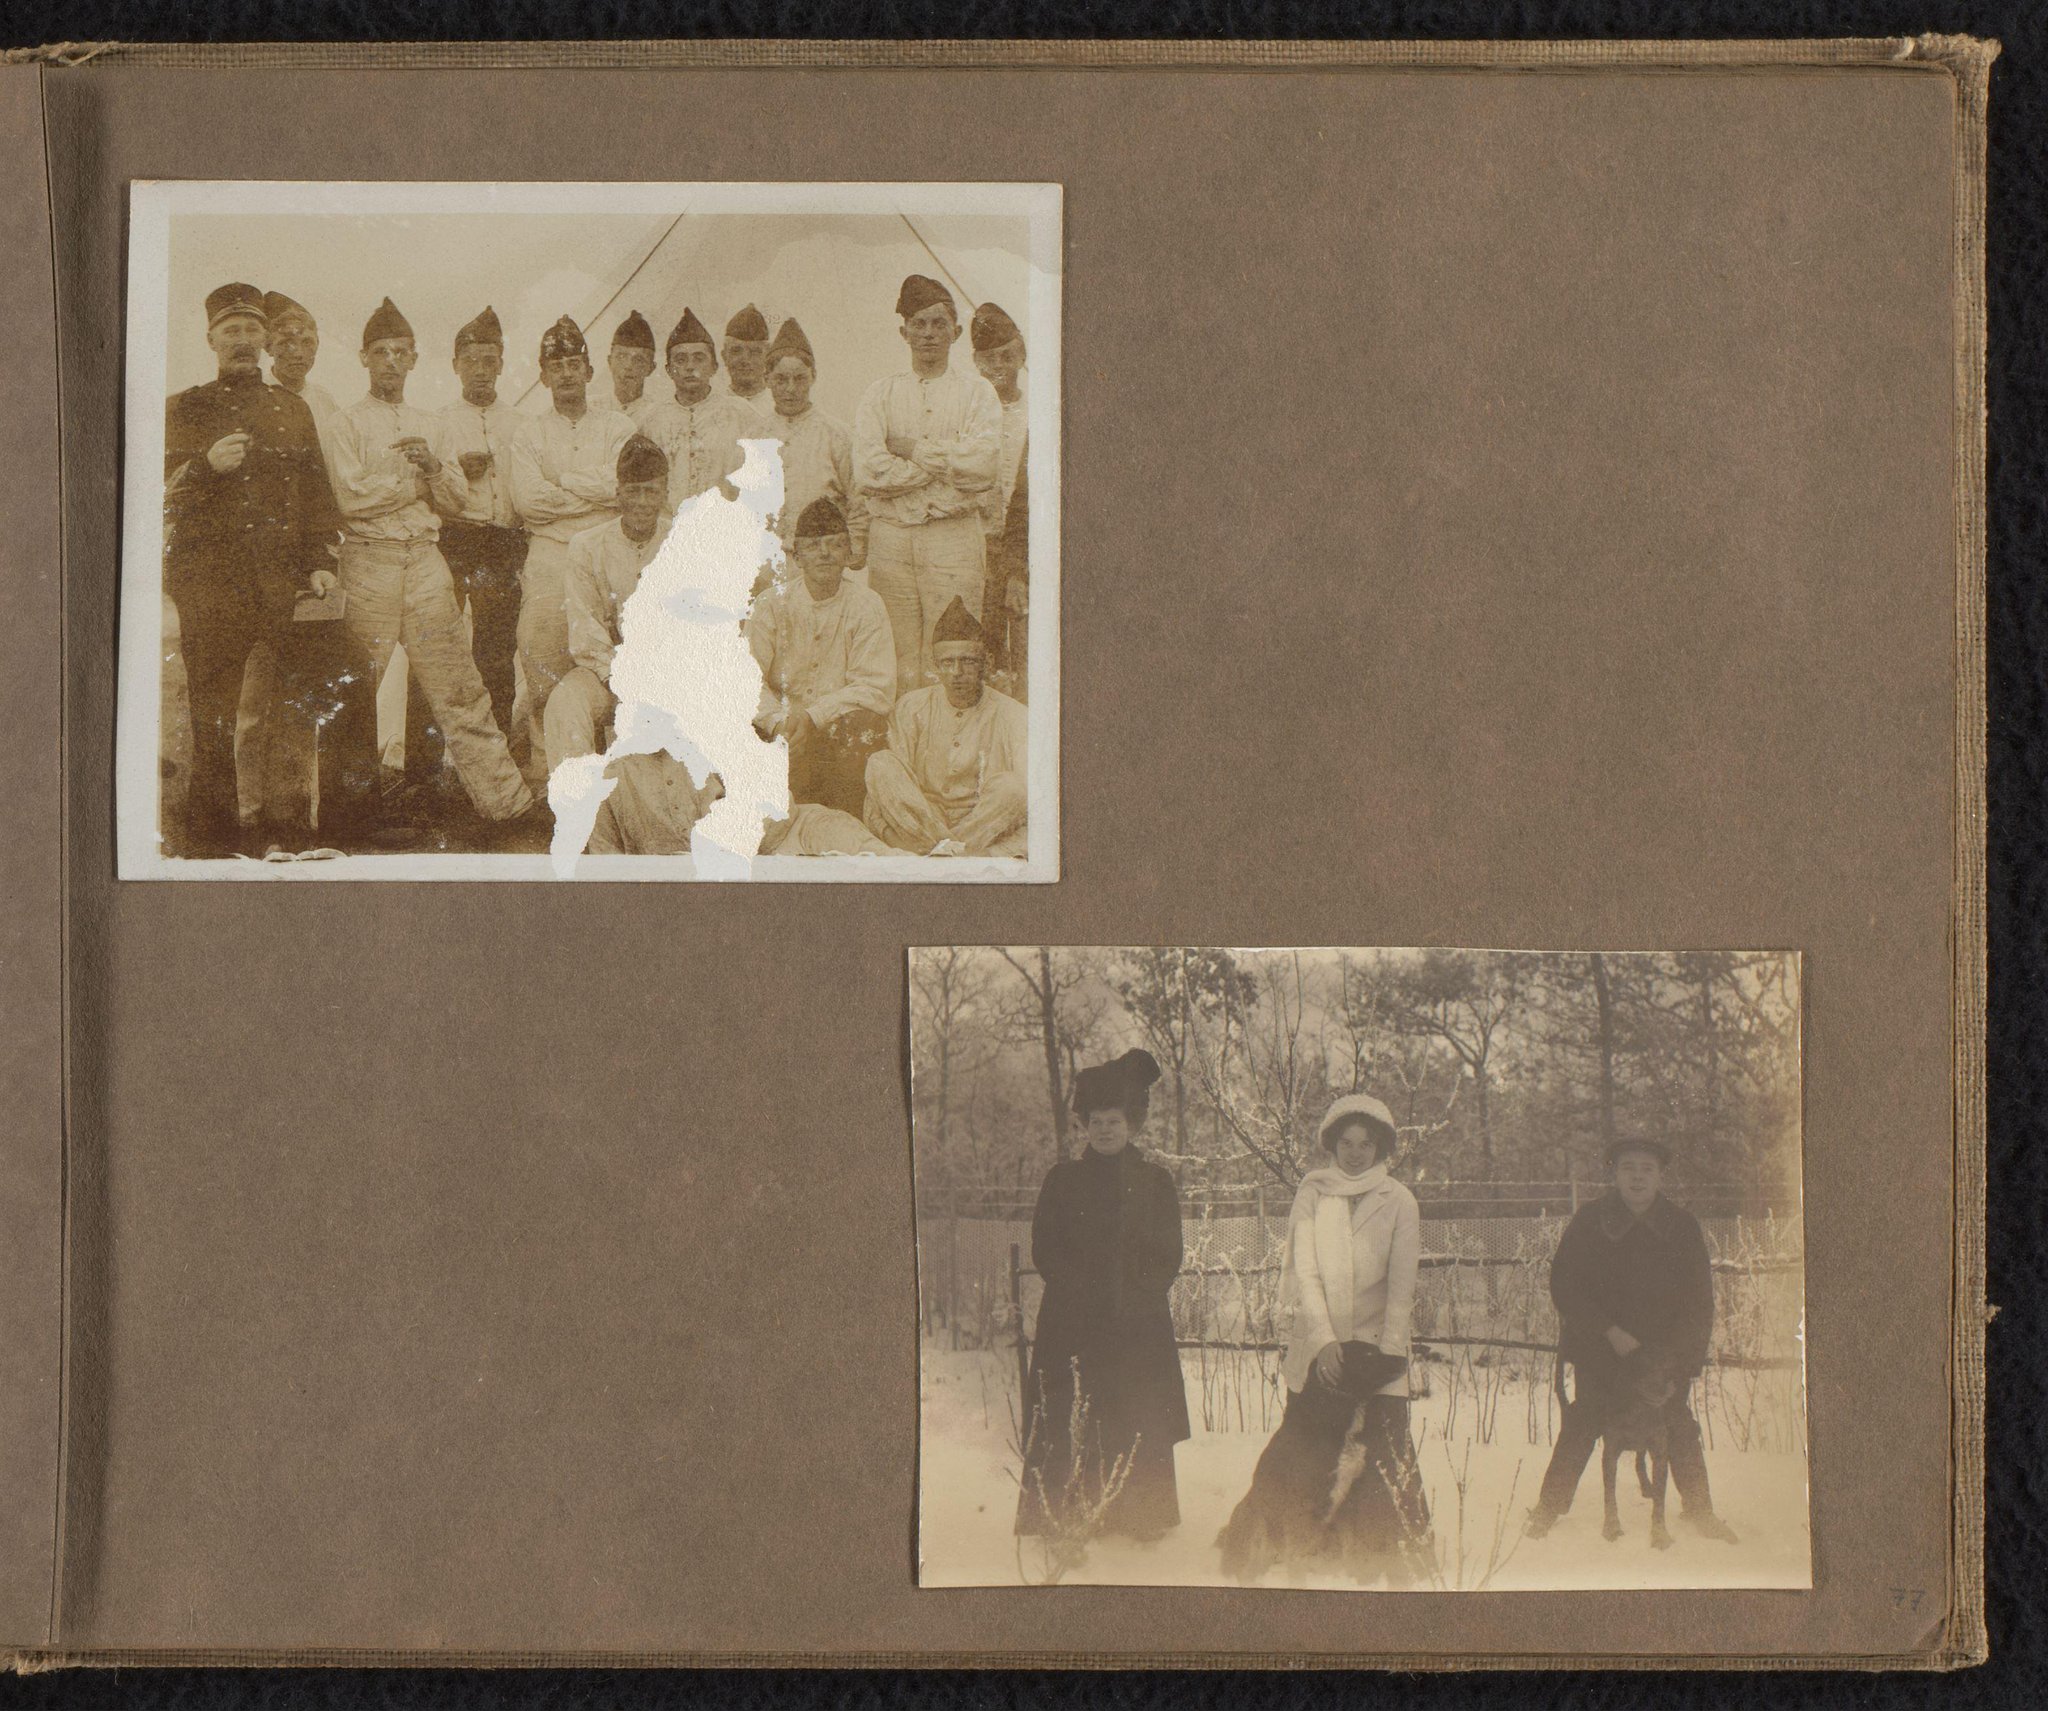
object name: photograph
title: Twee groepsportretten van een groep militairen en van drie mensen met honden in de sneeuw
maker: Anonymous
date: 1910-1911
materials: paper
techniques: gelatin silver print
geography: netherlands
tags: the company, the unit, the troop ~ military service, snow, dog, anonymous historical persons portrayed in a group, in a group-portrait, netherlands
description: Deze foto's maken deel uit van een album.